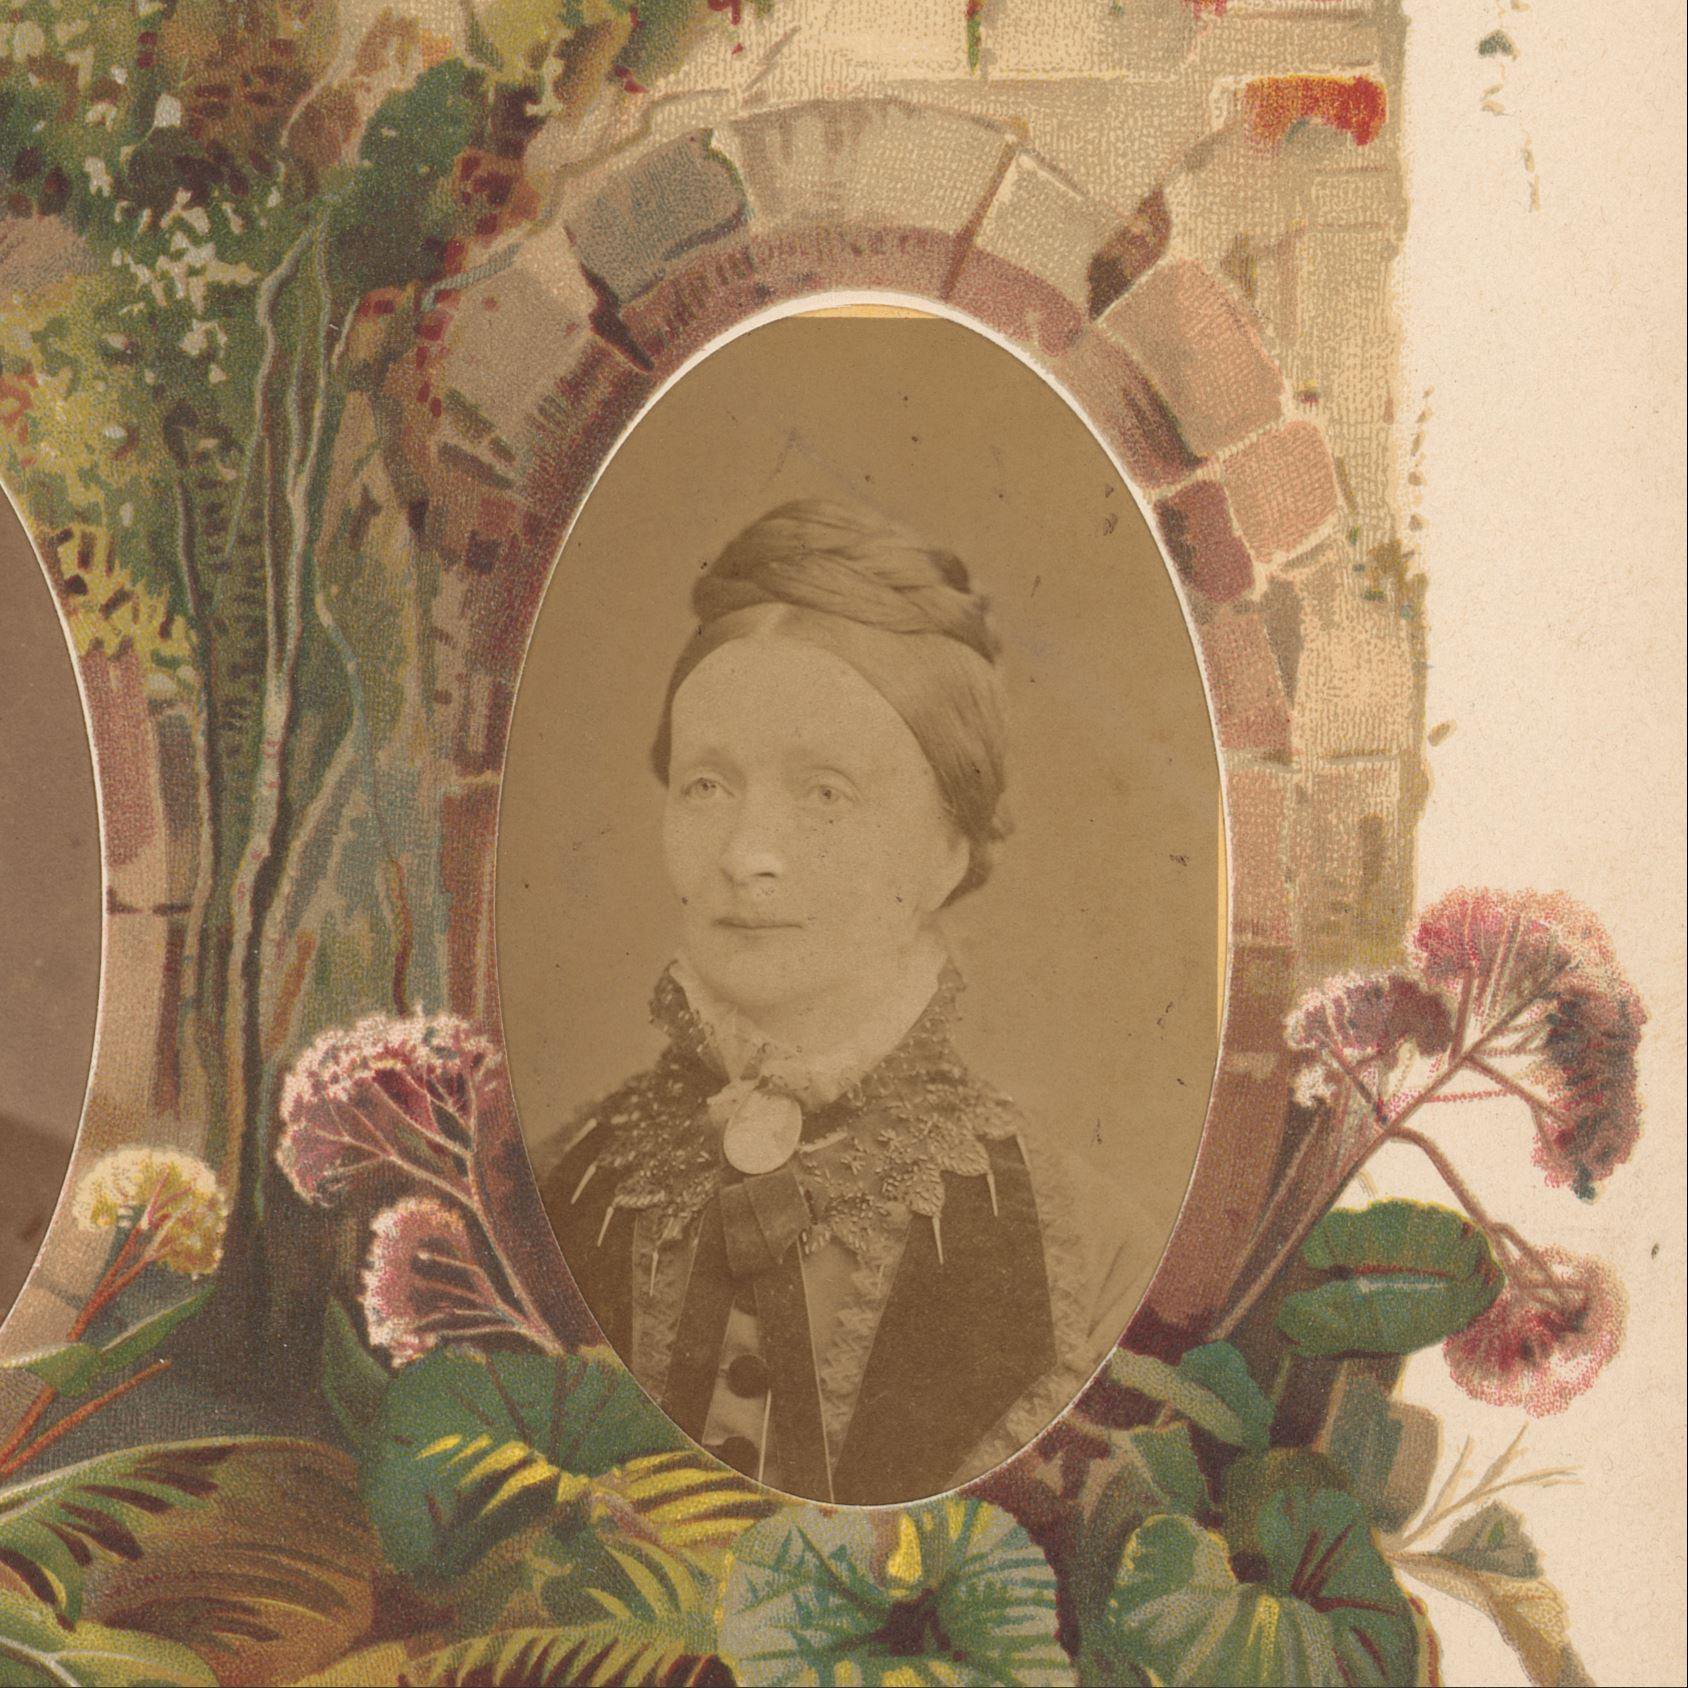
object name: photograph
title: Portret van een vrouw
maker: julius jr. ortgies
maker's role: fotograaf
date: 1850-1900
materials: cardboard, photographic support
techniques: albumen print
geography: bremen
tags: historical persons - bb - woman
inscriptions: inscription: ‘Photographie/ von/ Julius Ortgies Jr/ in/ BREMEN/ am Wall No 160./ zwischen dem Bischofs-u. Heerdenthor./ Zu Nachbestellungen wird die Originalplatte/ aufbewahrt.’